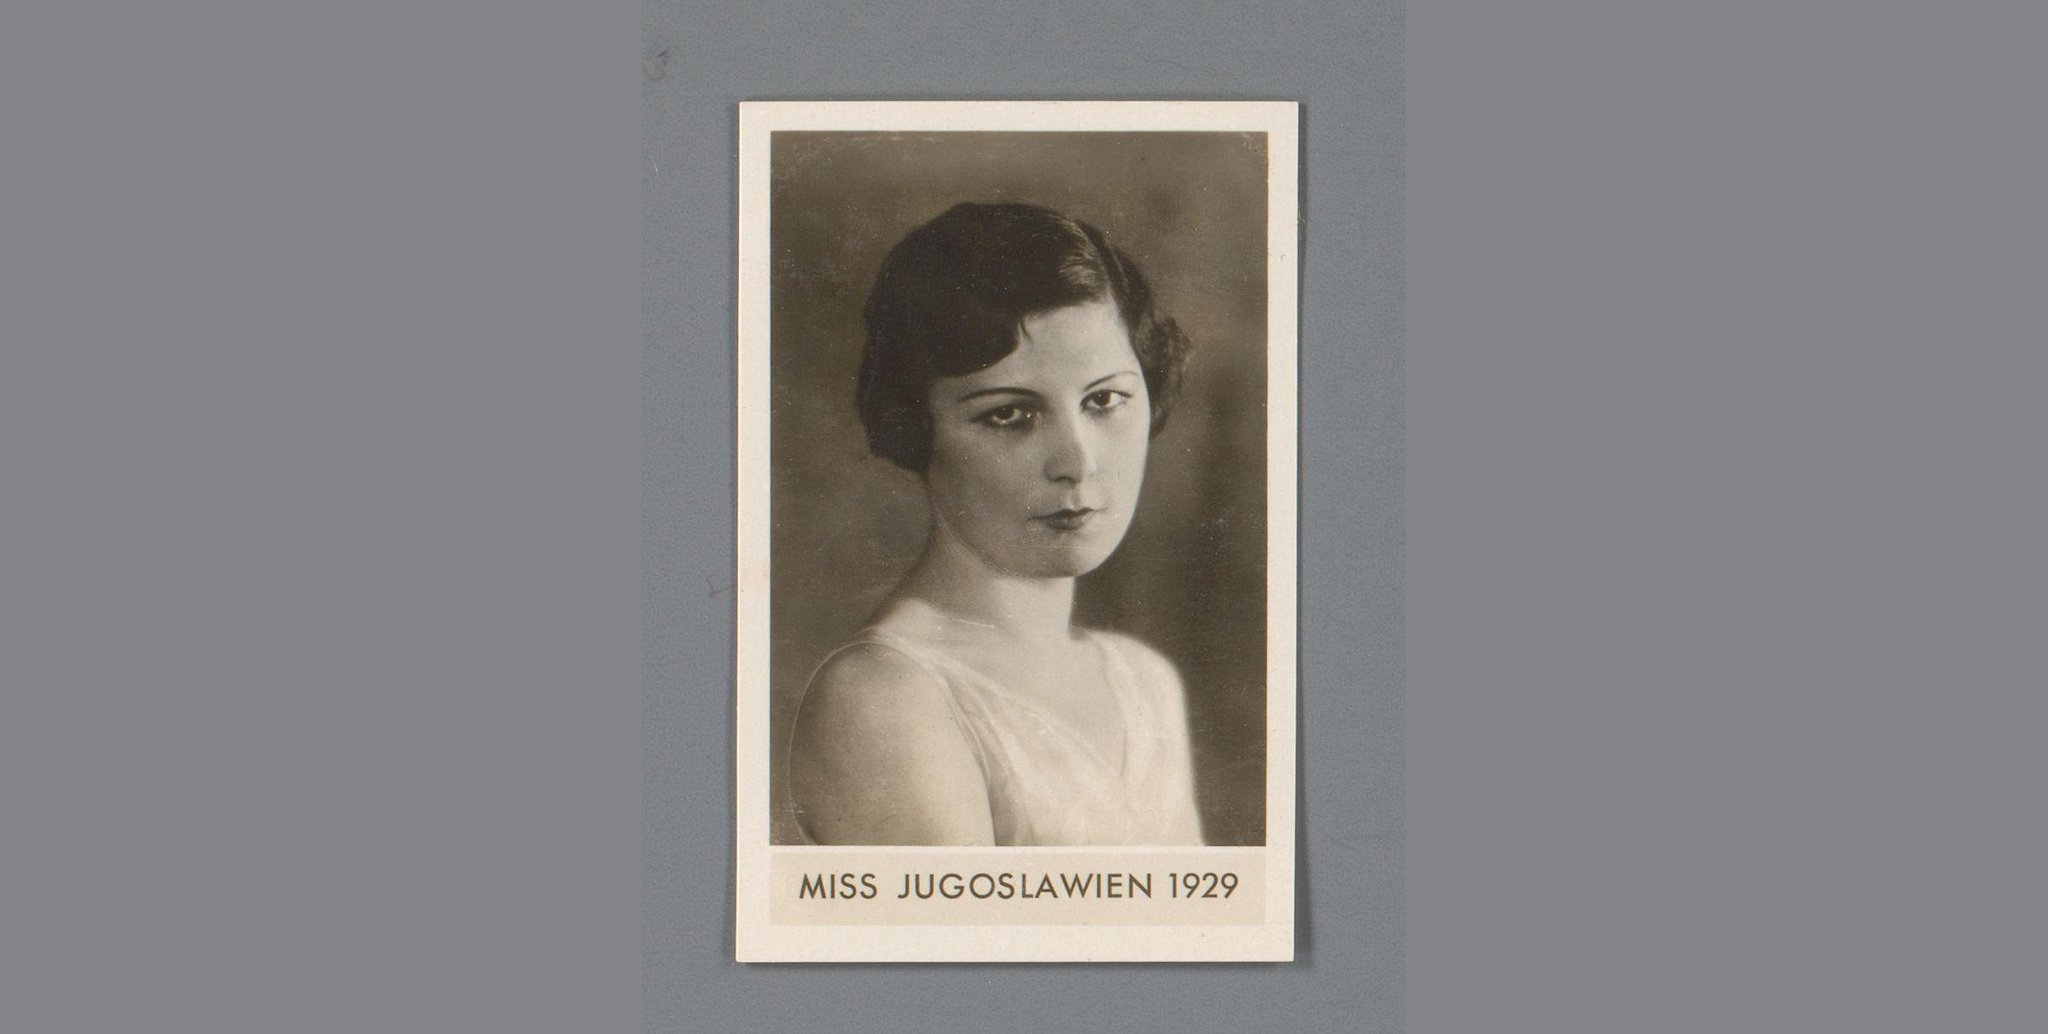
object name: photograph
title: Miss Jugoslawien 1929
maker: Anonymous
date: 1929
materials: paper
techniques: gelatin silver print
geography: dresden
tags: historical persons - bb - woman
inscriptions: inscription: ‘Die schönsten/ Frauen der Welt/ dargestellt durch die Schön-/ heitsköniginnen aller Länder,/ finden Sie in 190 echten/ Bromsilber-Fotos, die nur den/ CLUB-und-LIGA-Packun-/ gen beiliegen. Eind prächtiges/ Sammel-Album erhalten Sie/ für 75 Pfennig vom Händler/ oder bei Einsendung von/ 75 Pfennig in Briefmarken/ von der Bilderstelle Lohse,/ Dresden A24, Nossener Str. 1./ Ges. gesch. Nachdruck verboten!’